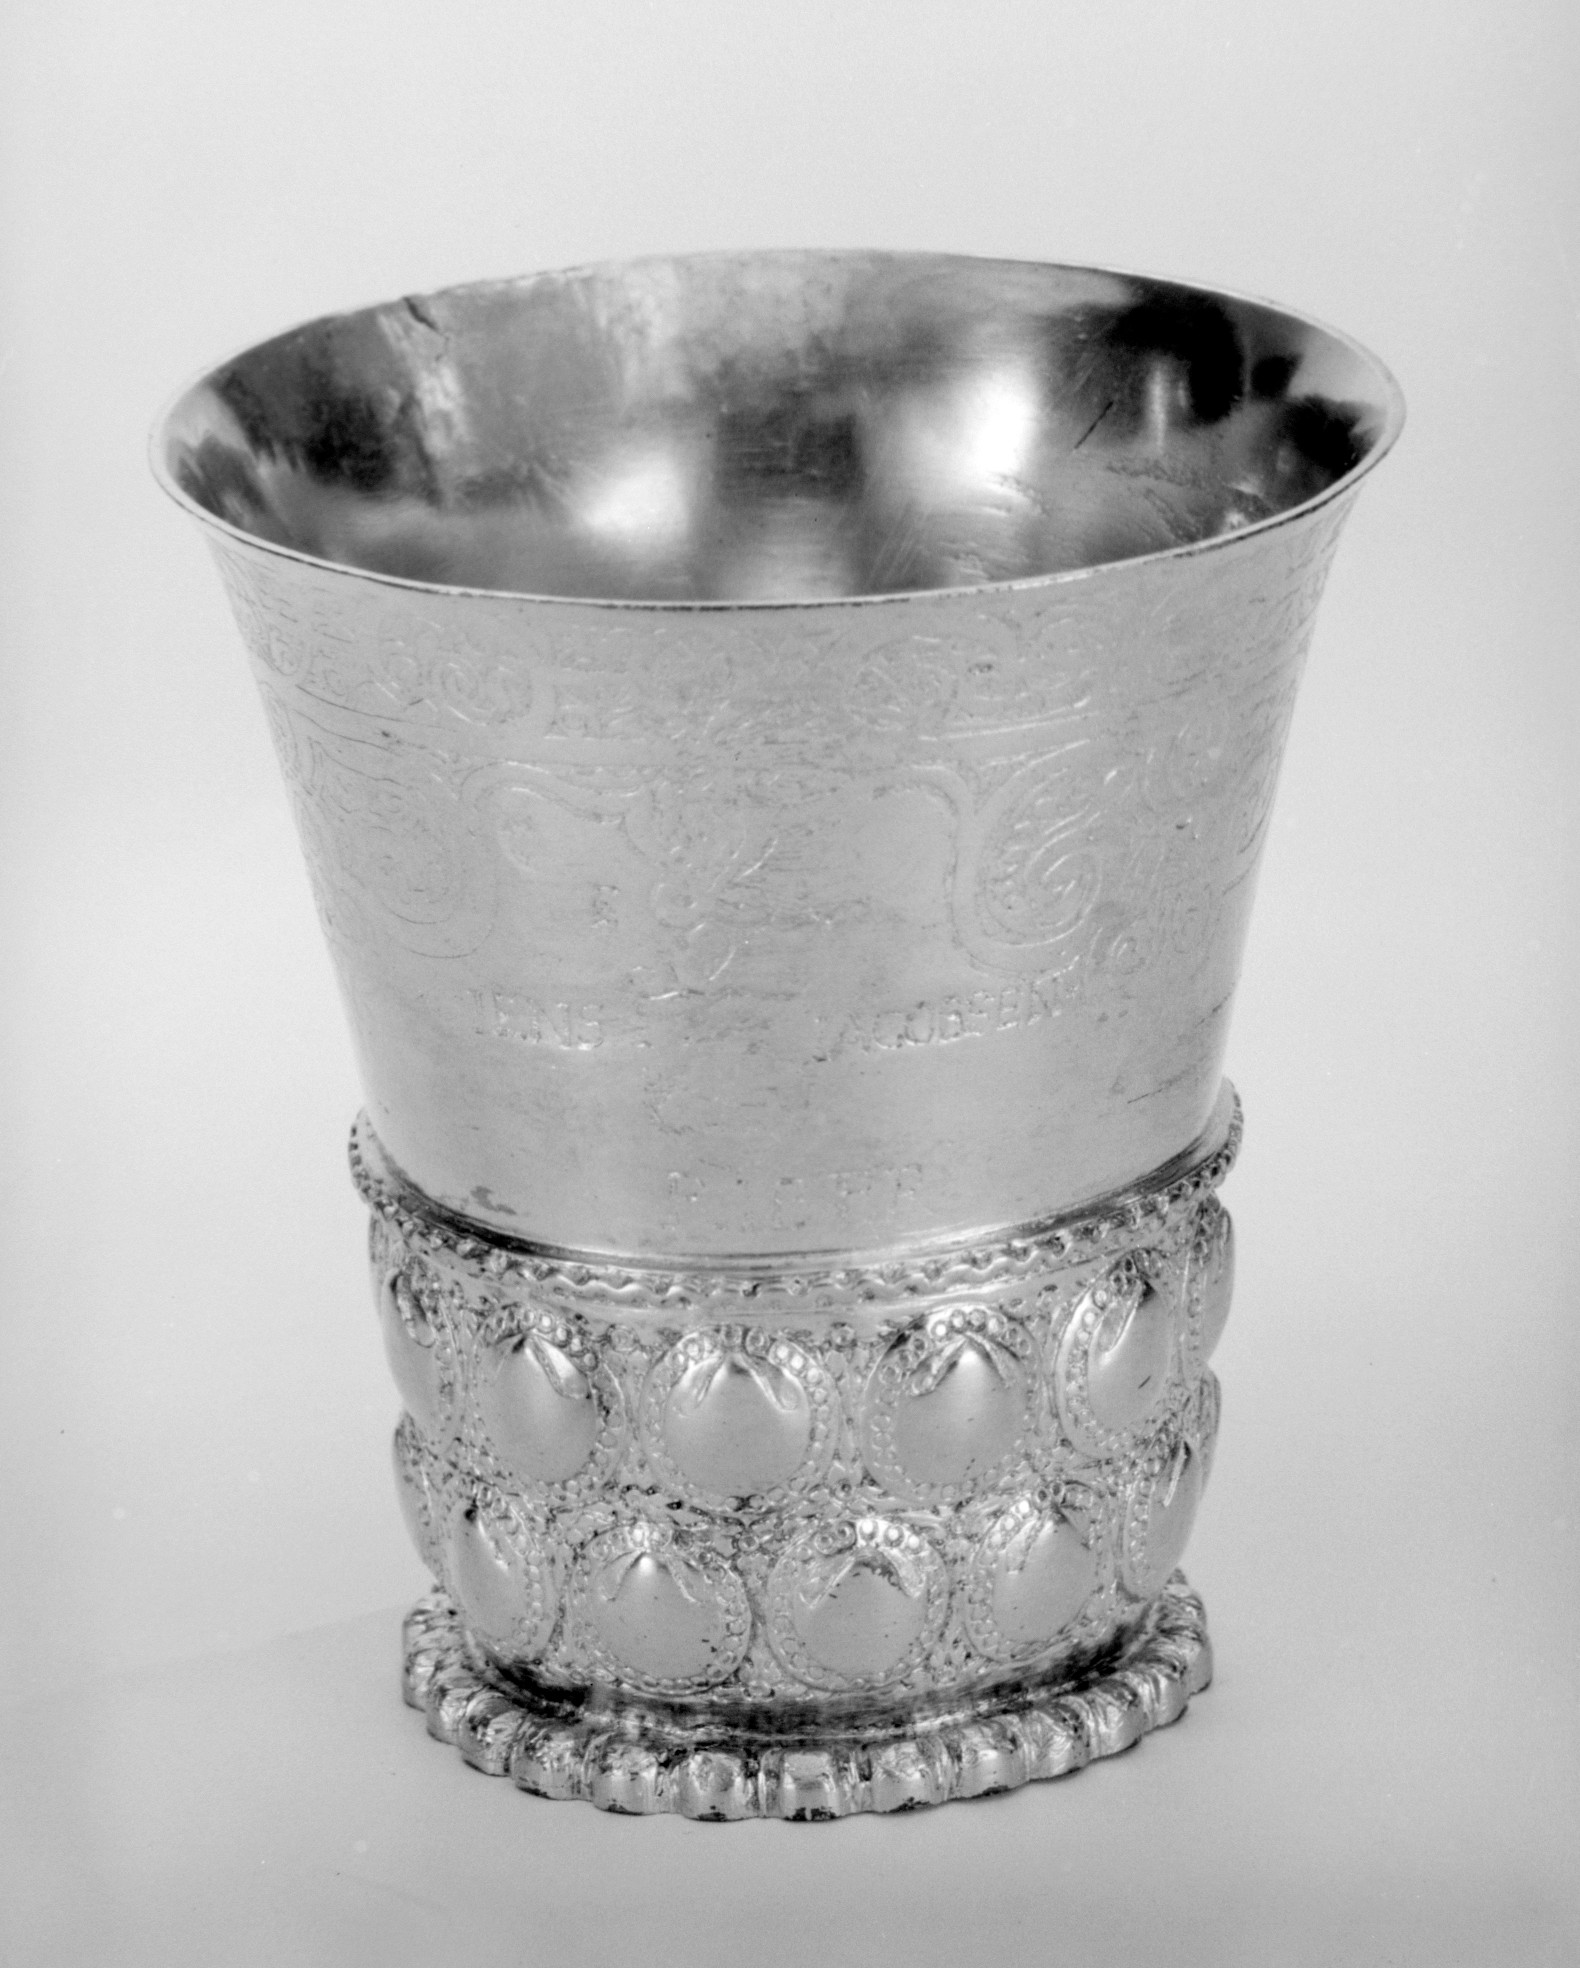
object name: beaker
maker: franchi and son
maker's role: manufacturer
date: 1801-1900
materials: metal, silver